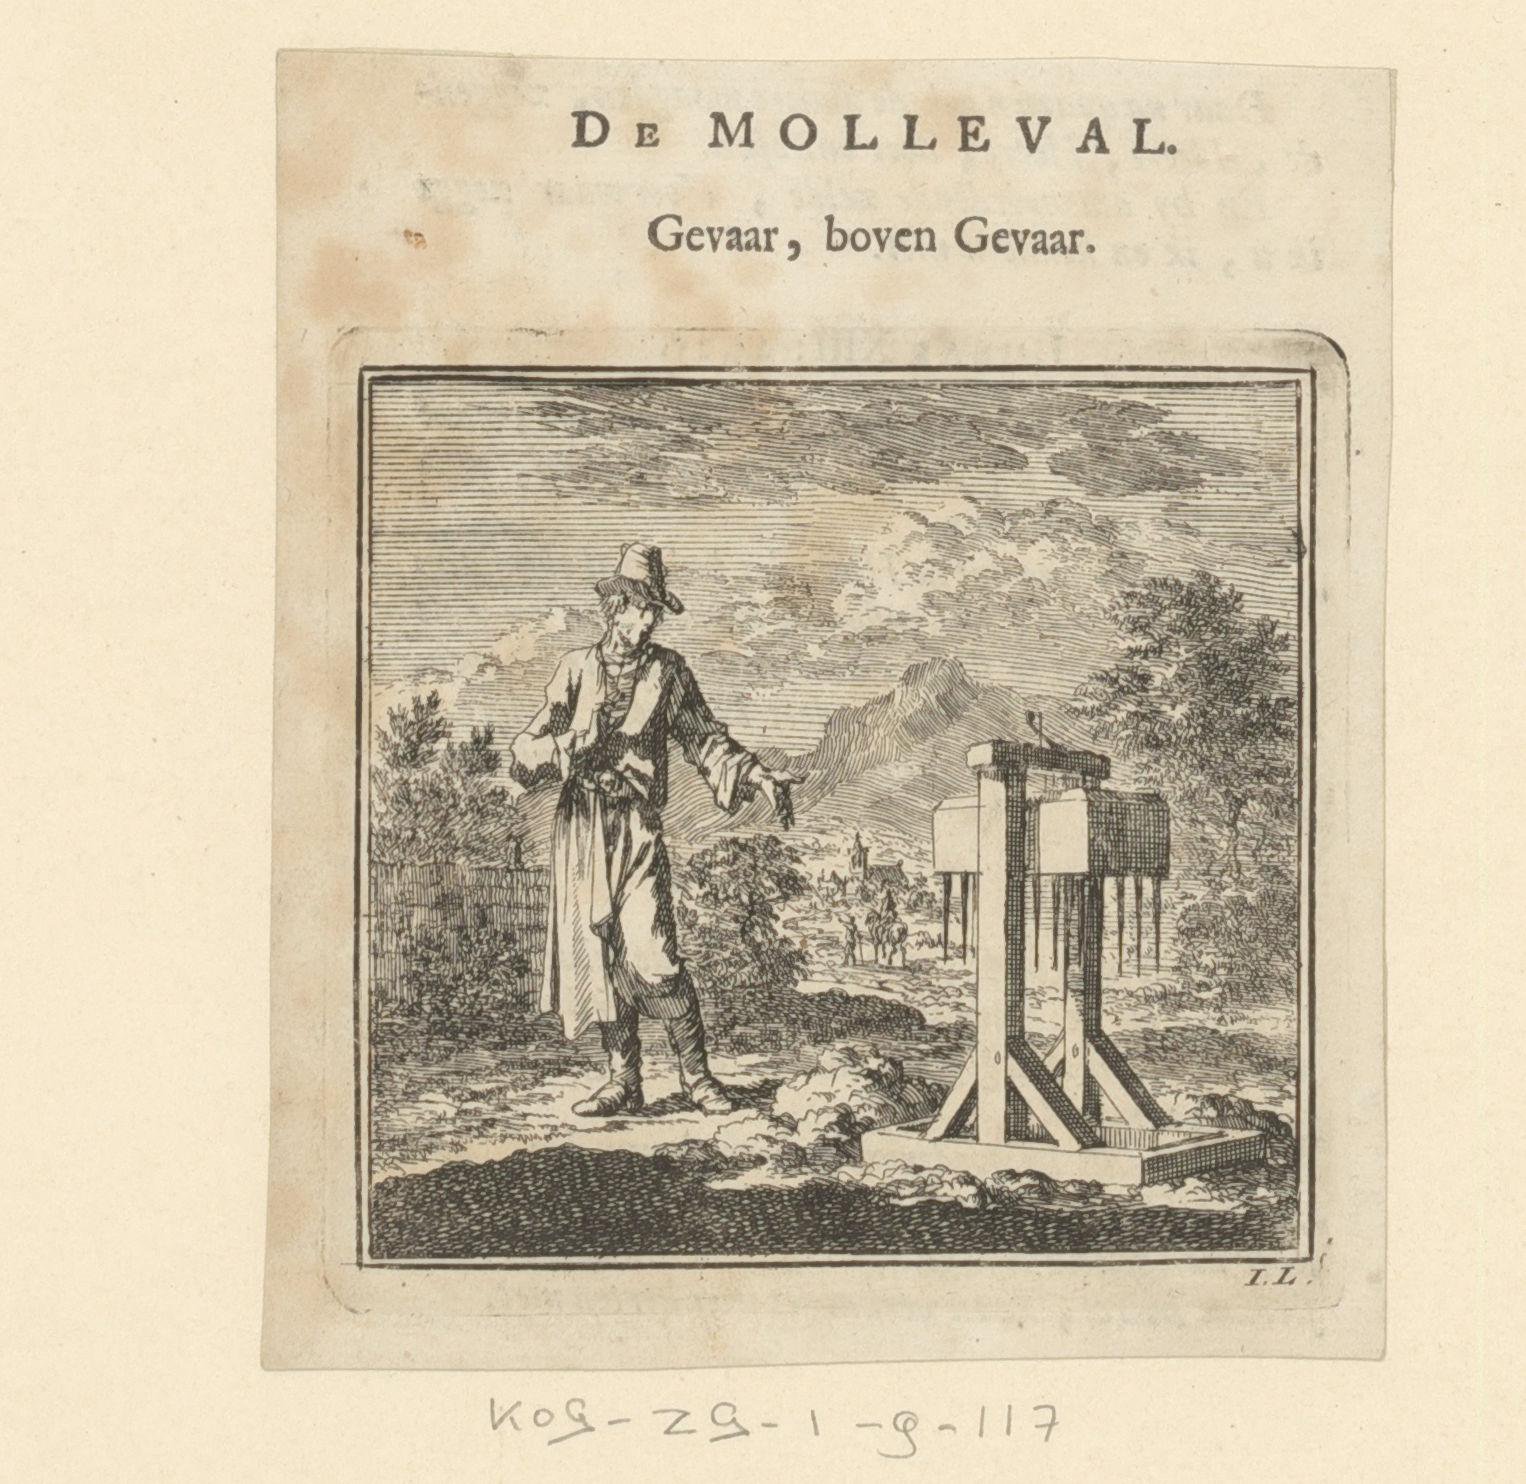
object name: print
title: De Molleval, Gevaar, boven Gevaar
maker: jan luyken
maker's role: draughtsman, print maker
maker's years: 1649-1712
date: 1711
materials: paper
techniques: etching, letterpress printing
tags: control and eradication of injurious animals, other mammals: mole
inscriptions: stamp, collector's mark: Lugt 1641, stamp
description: Prent waarschijnlijk uit: Luyken, Jan. De Bykorf des Gemoeds. Amsterdam: Pieter Arentsz. II (wed.) en Cornelis van der Sys, 1711, p. 74.